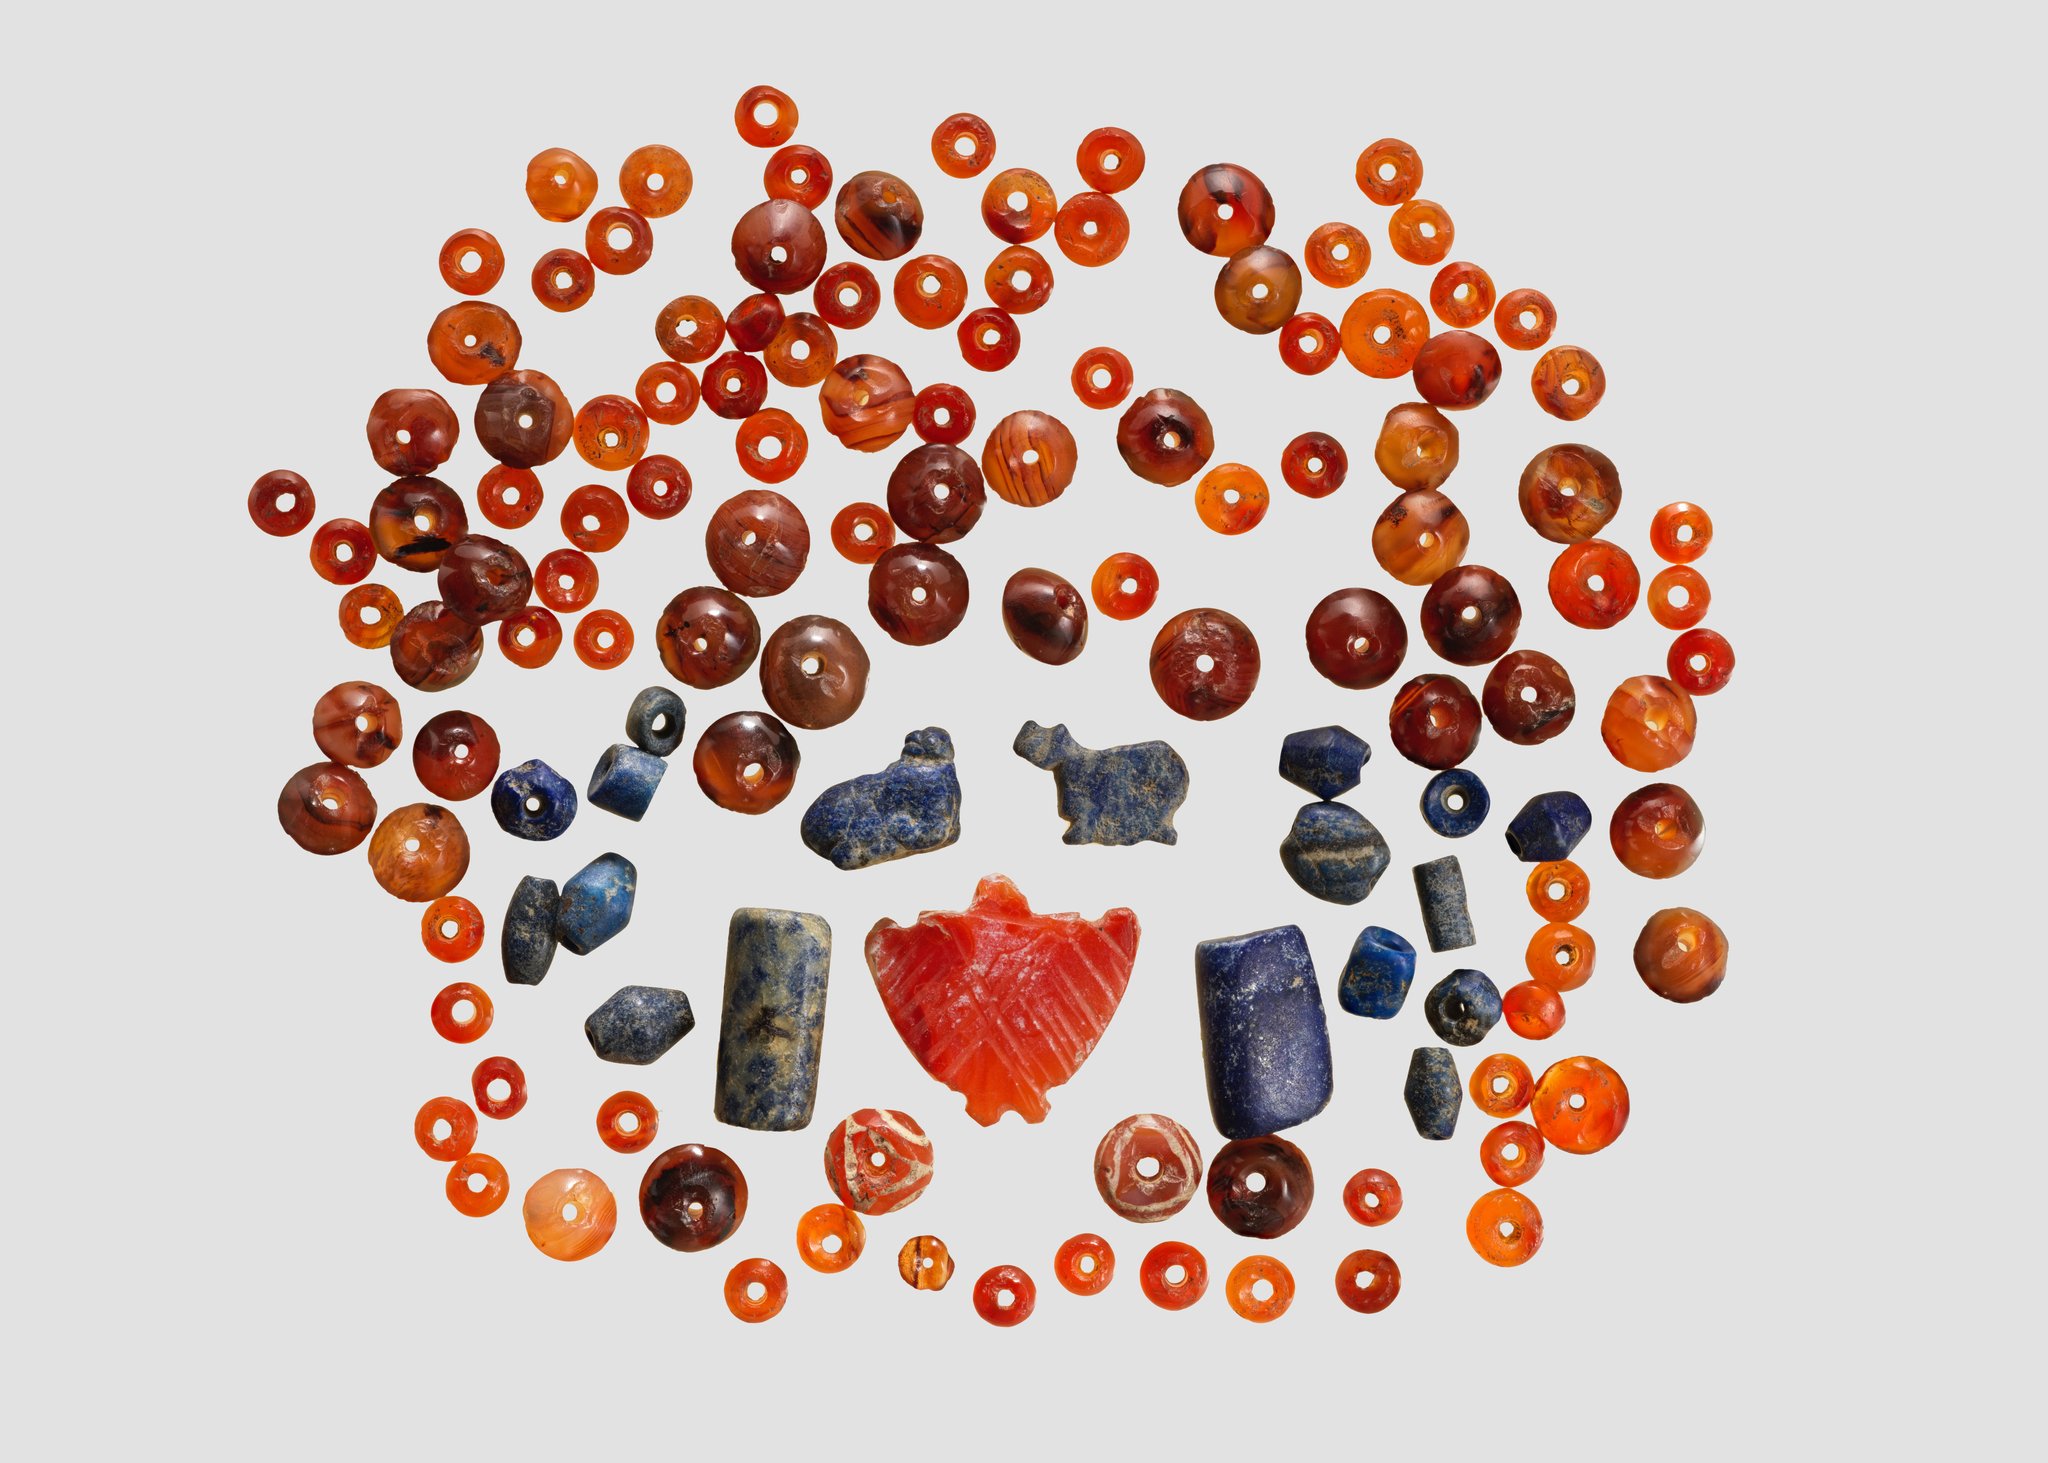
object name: bead and pendant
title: Pendant and beads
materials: gemstone, lapis lazuli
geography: syria